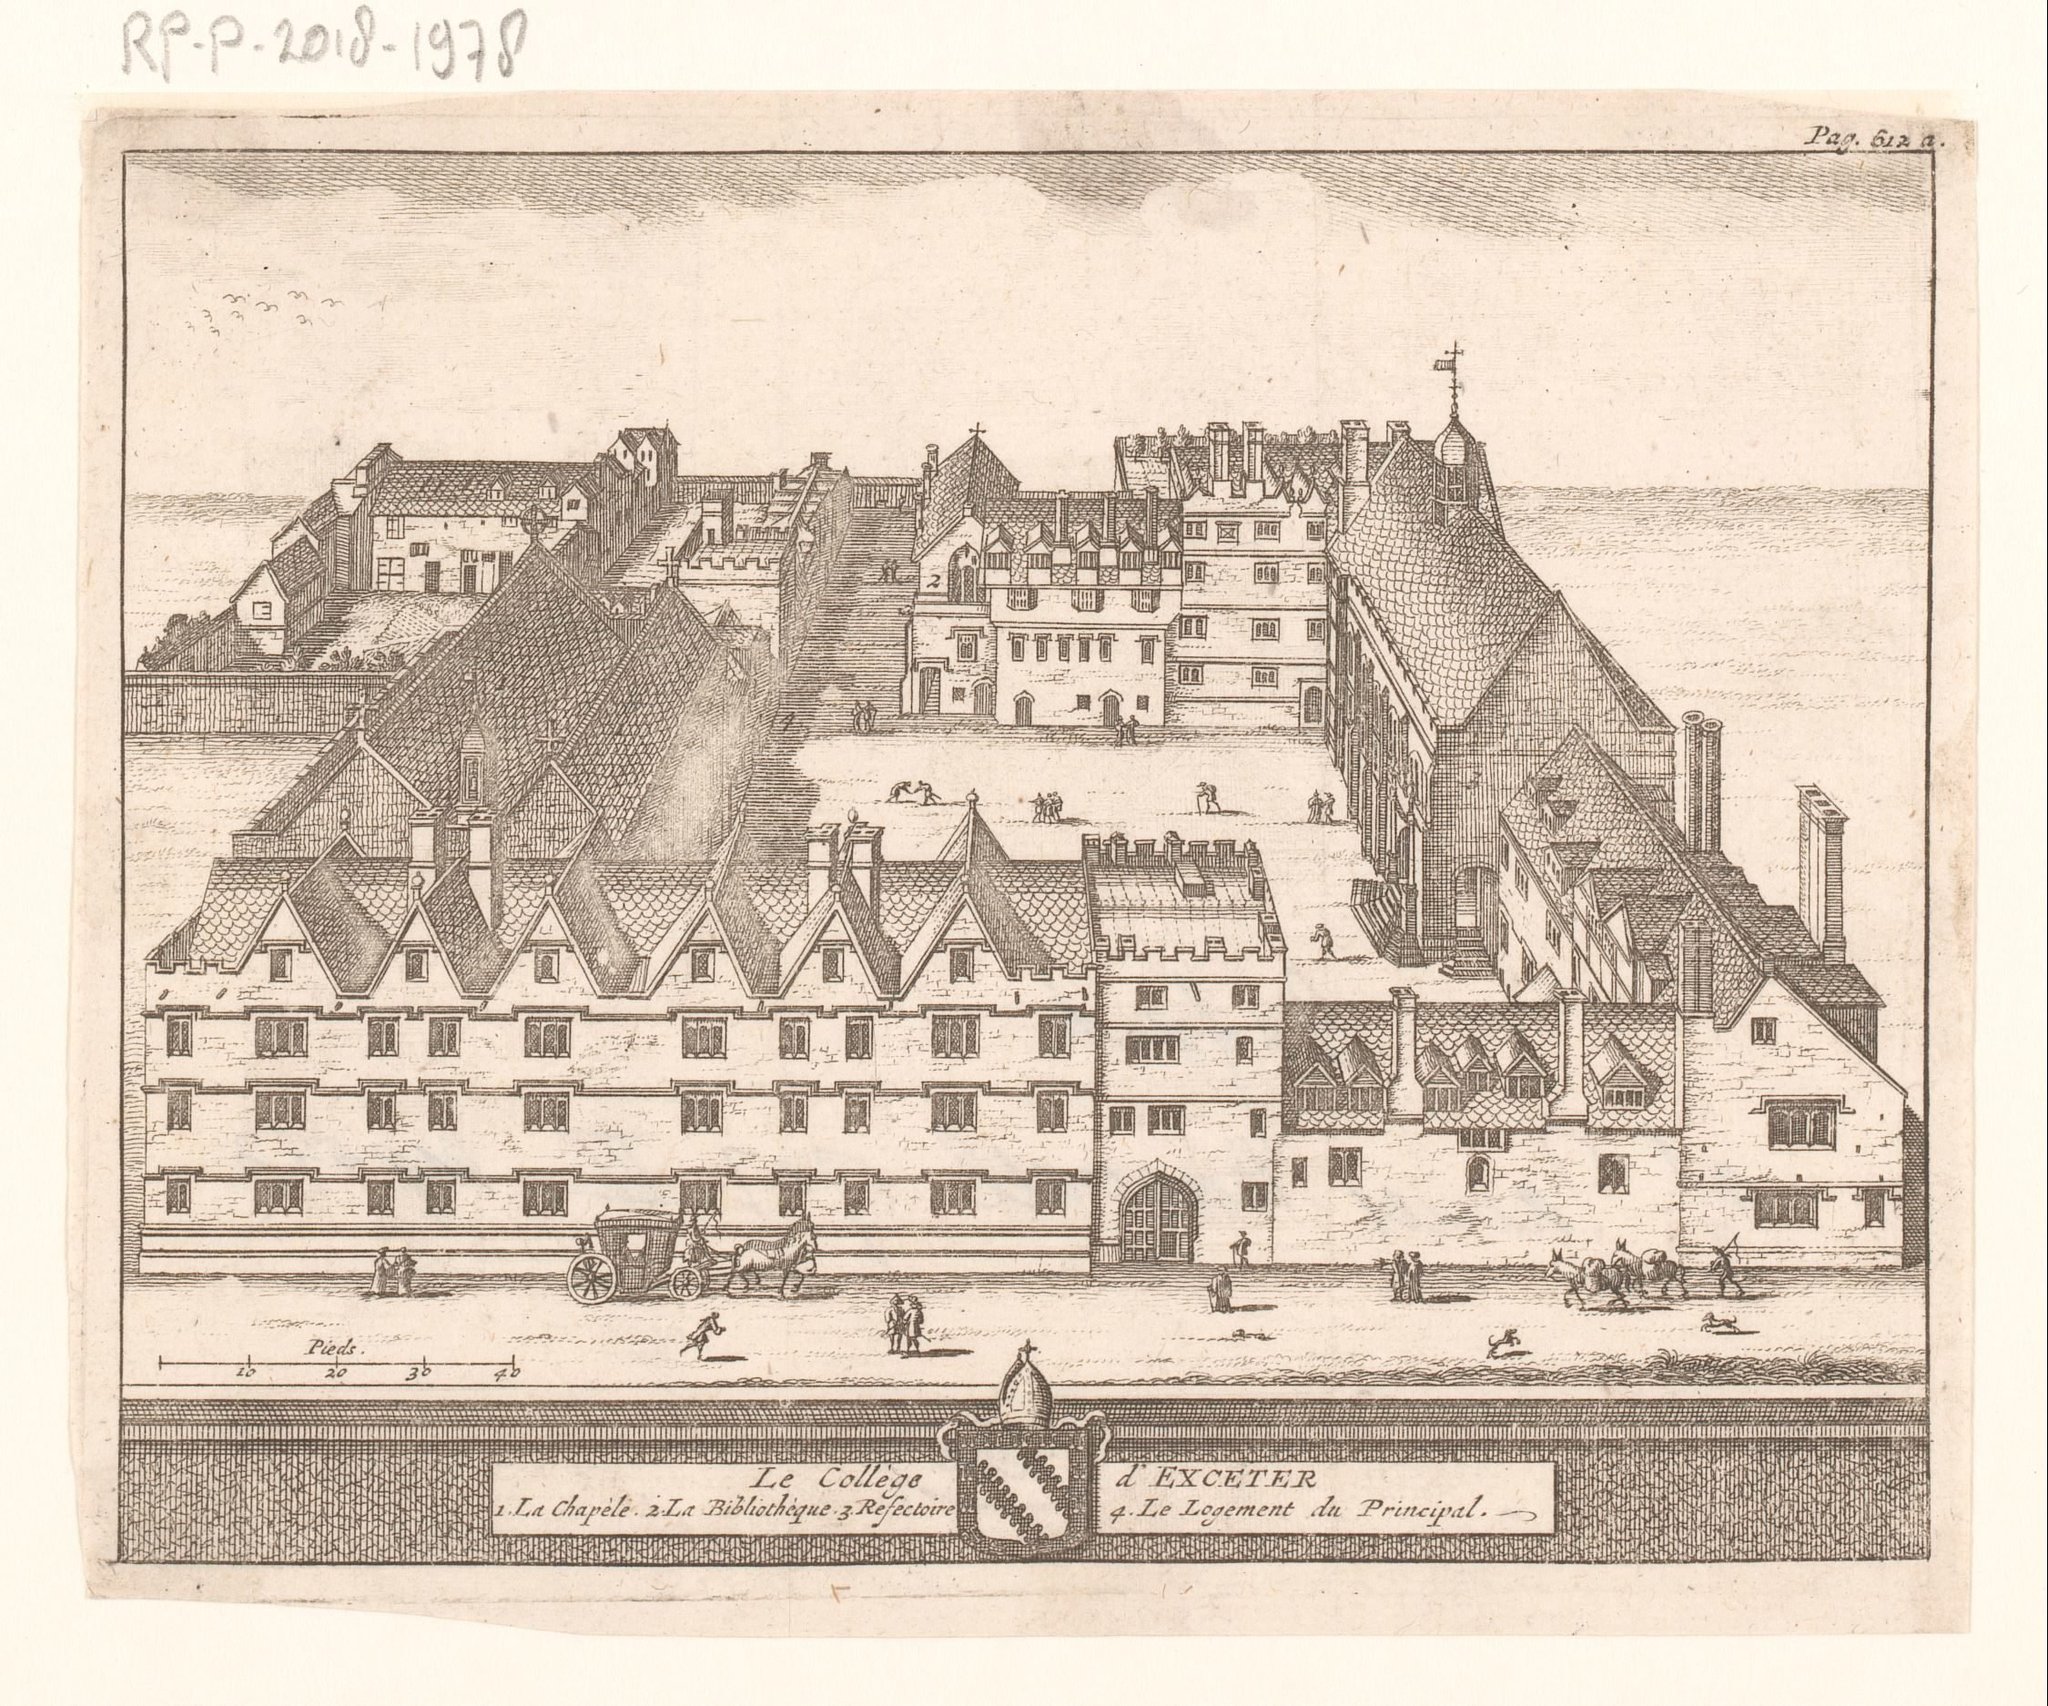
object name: print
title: Le Collège d'Exceter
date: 1707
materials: paper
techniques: etching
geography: leiden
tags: university building, college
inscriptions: collector's mark: Lugt 2228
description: Prent gebruikt in: Beeverell, James. Les Delices de la Grande Bretagne et de l'Irlande (...). Leiden: Pieter van der Aa, 1707.